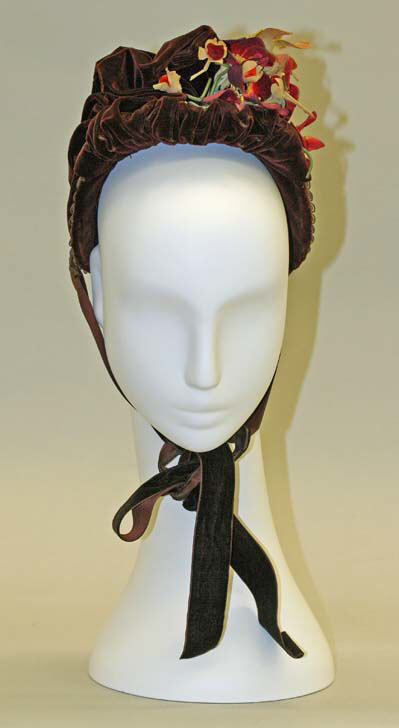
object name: hat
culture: american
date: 1880-1889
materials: silk, fiber